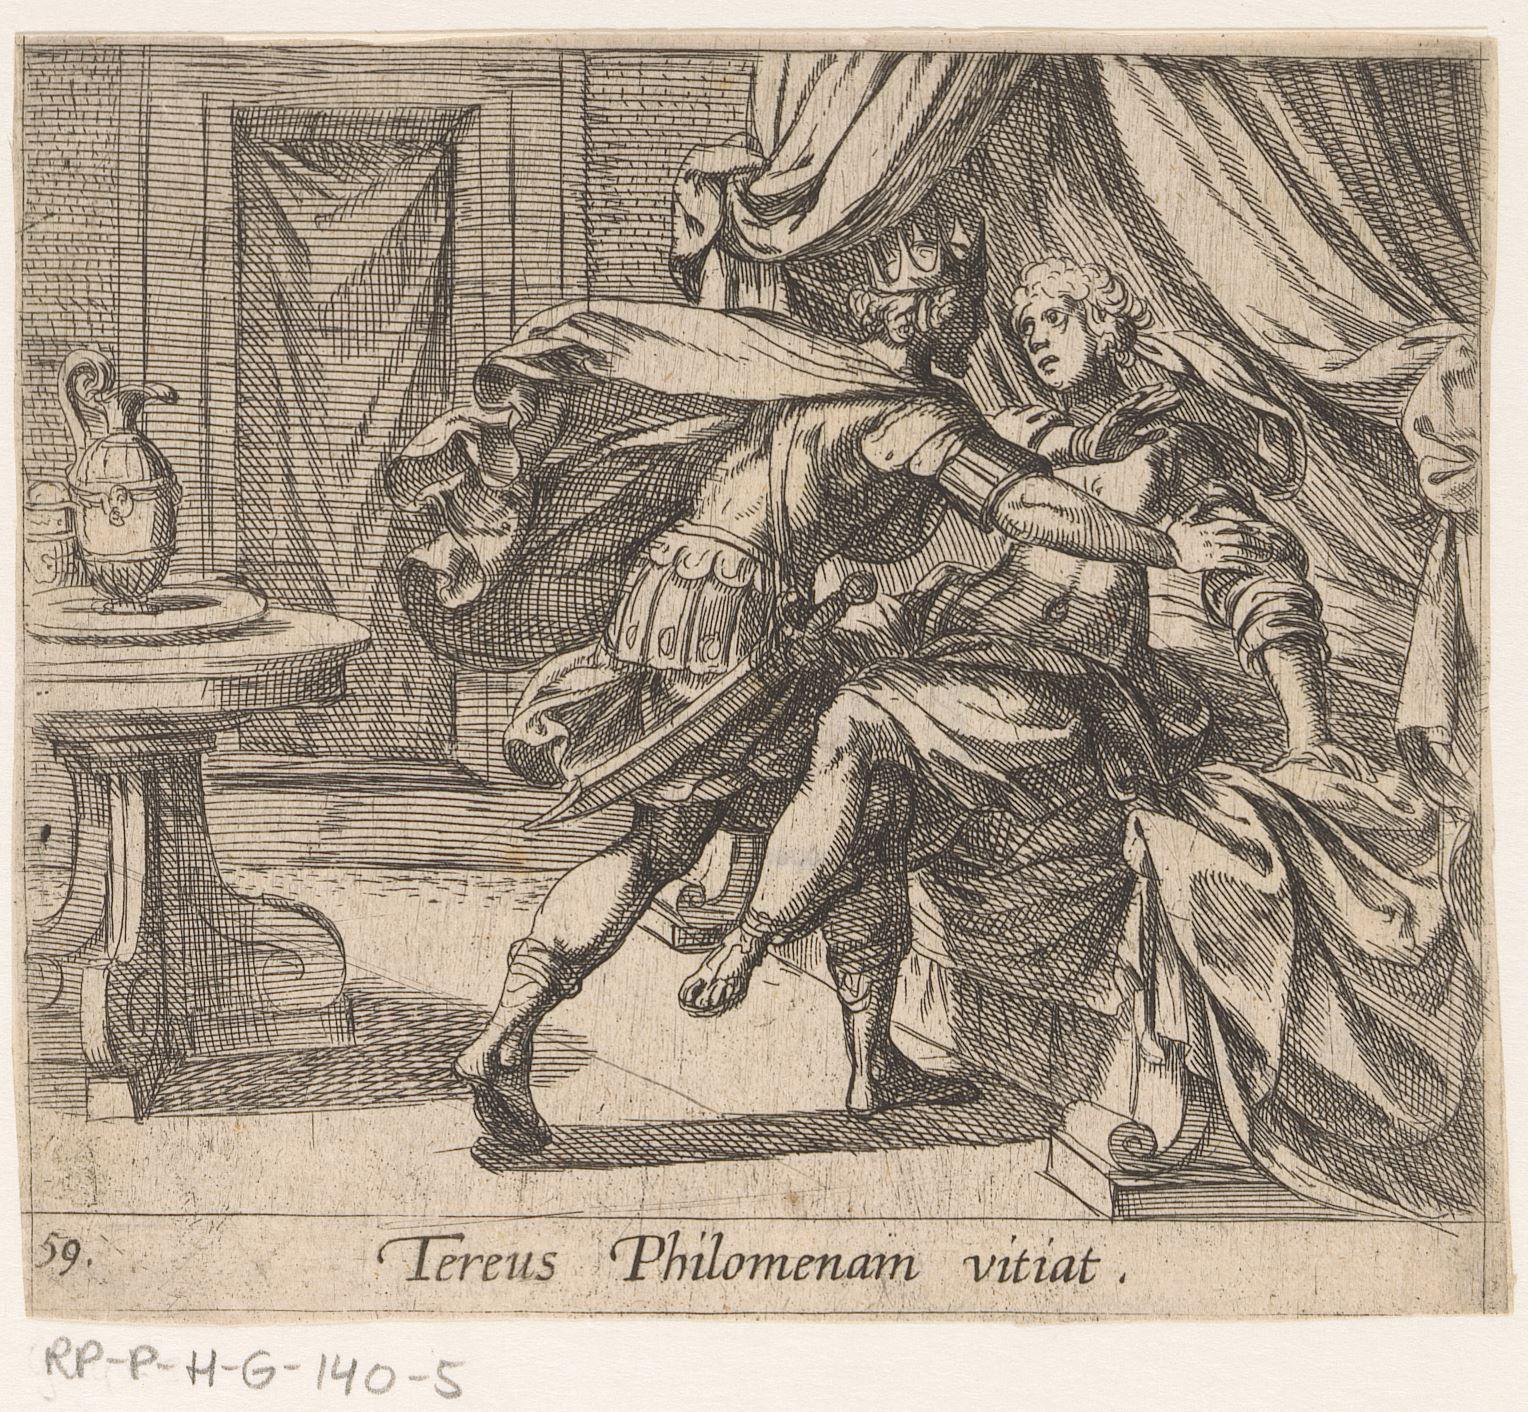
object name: print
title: Verkrachting van Philomela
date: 1606-1638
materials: paper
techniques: etching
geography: italy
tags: tereus offers violence to philomela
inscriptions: collector's mark: ‘Hinloopen’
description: Deze prent maakt deel uit van een reeks van 150 prenten (+ titelprent) met voorstellingen van de Metamorfosen van Ovidius.